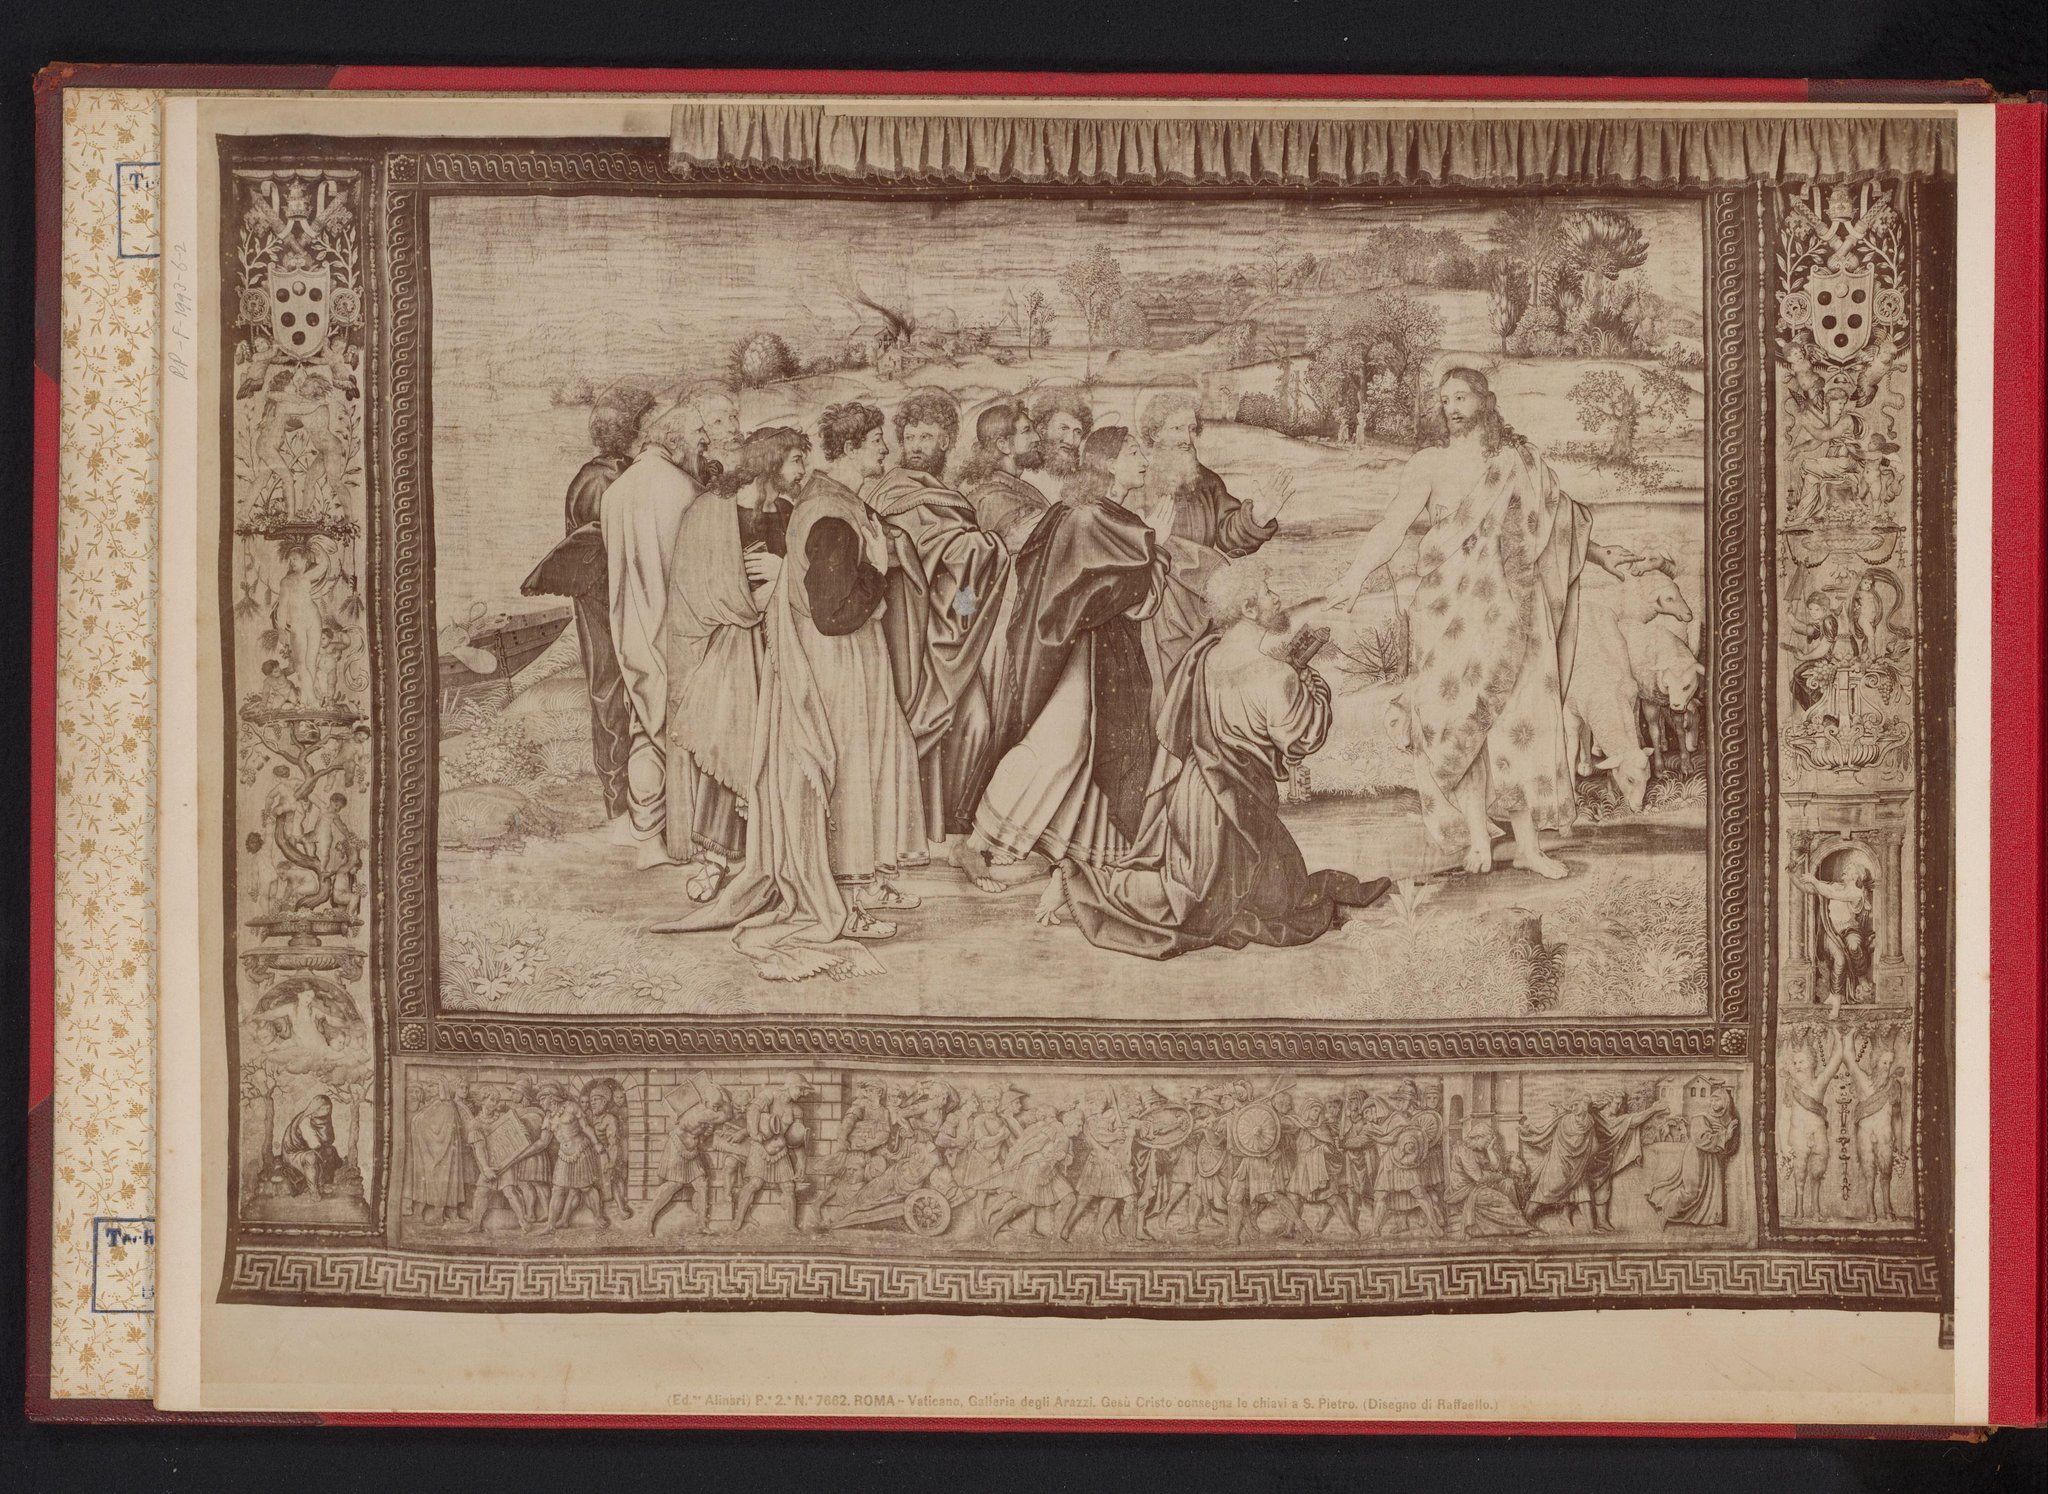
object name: reproduction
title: Fotoreproductie van tapijt Christus overhandigt Petrus de sleutels, Galleria degli Arezzi, Vaticaan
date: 1860-1900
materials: paper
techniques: albumen print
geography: florence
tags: christ gives the keys of heaven to peter, tapestry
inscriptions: inscription: ‘(Ed.ne Alinari) P.e 2.a N.o 7662. ROMA - Vaticano, Galleria degli Arazzi. Gesù Cristo consegna le chiavi a S. Pietro. (Disegno di Raffaello.)’